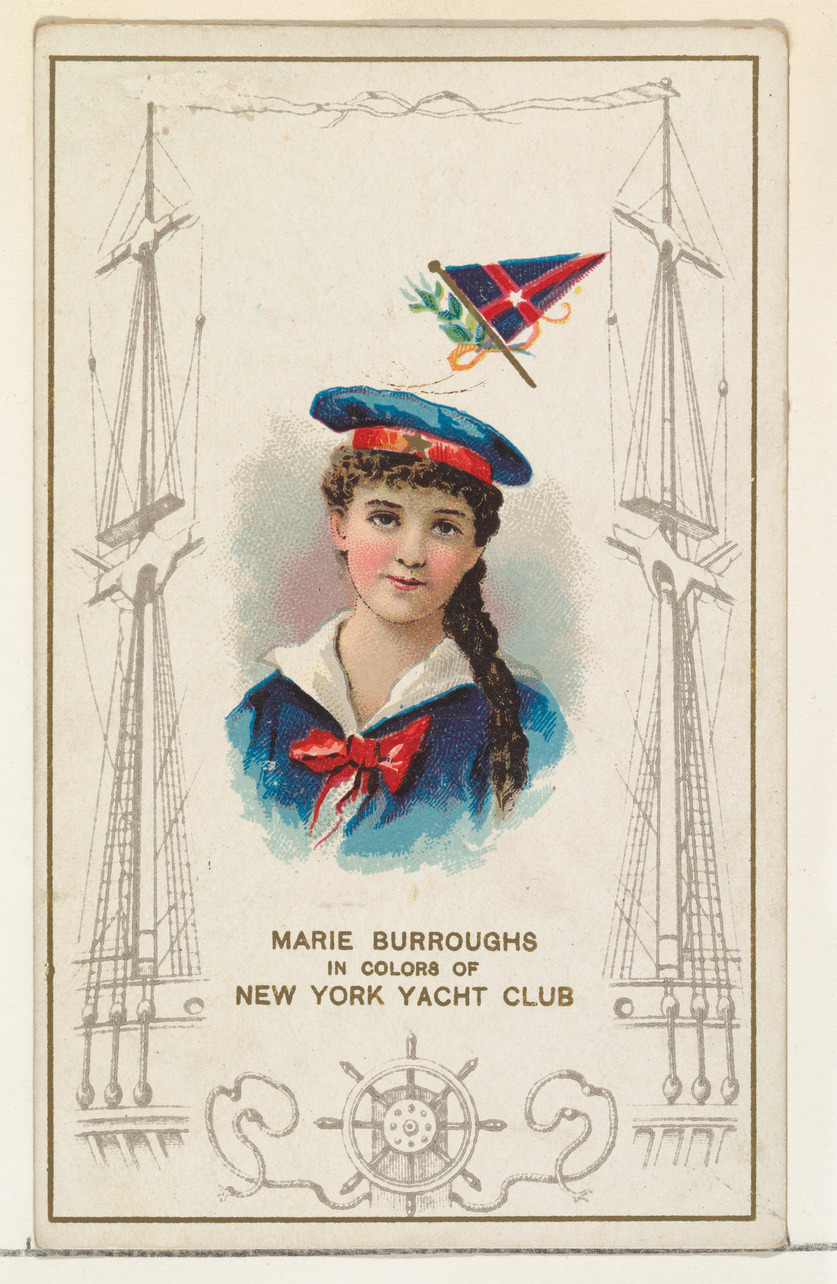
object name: print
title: Marie Burroughs in Colors of the New York Yacht Club, from the Yacht Colors of the World series (N140) issued by Duke Sons & Co. to promote Honest Long Cut Tobacco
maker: w. duke, sons & co.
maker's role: publisher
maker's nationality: american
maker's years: 1870-1920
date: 1890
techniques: color lithograph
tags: portraits,women,flags